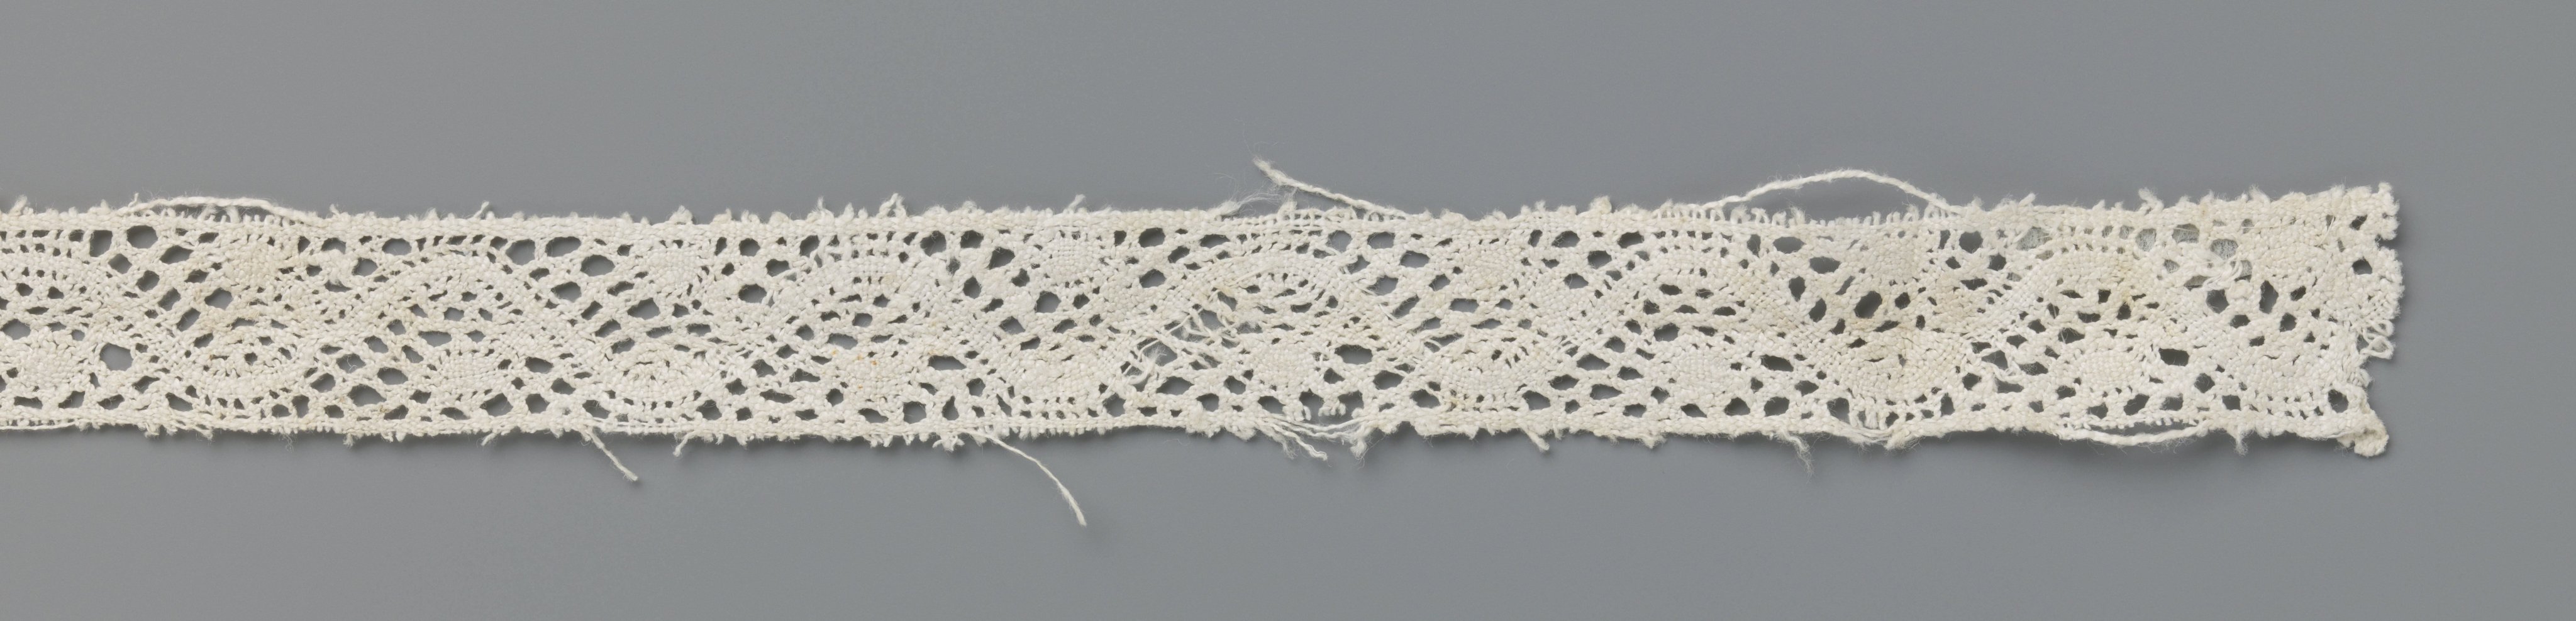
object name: strip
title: Tussenzetsel van kloskant met golvende middenlijn en losse ovaaltjes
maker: Anonymous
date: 1600-1624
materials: linen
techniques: lace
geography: friesland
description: Tussenzetsel van naturelkleurige kloskant. Het patroon bestaat uit een regelmatig golvende smalle middenlijn met een los ovaaltje onder elke golftop en in elk golfdal. De motieven zijn met elkaar verbonden door maasgrond. De motieven zijn gemaakt in linnenslag met opengewerkte randjes. Boven- en onderzijde van de strook zijn recht afgewerkt, waarbij de onderzijde oorspronkelijk was voorzien van picots, maar deze zijn door de rafelig geworden randen niet meer zichtbaar. Het tussenzetsel is afkomstig van of bedoeld voor beddengoed.